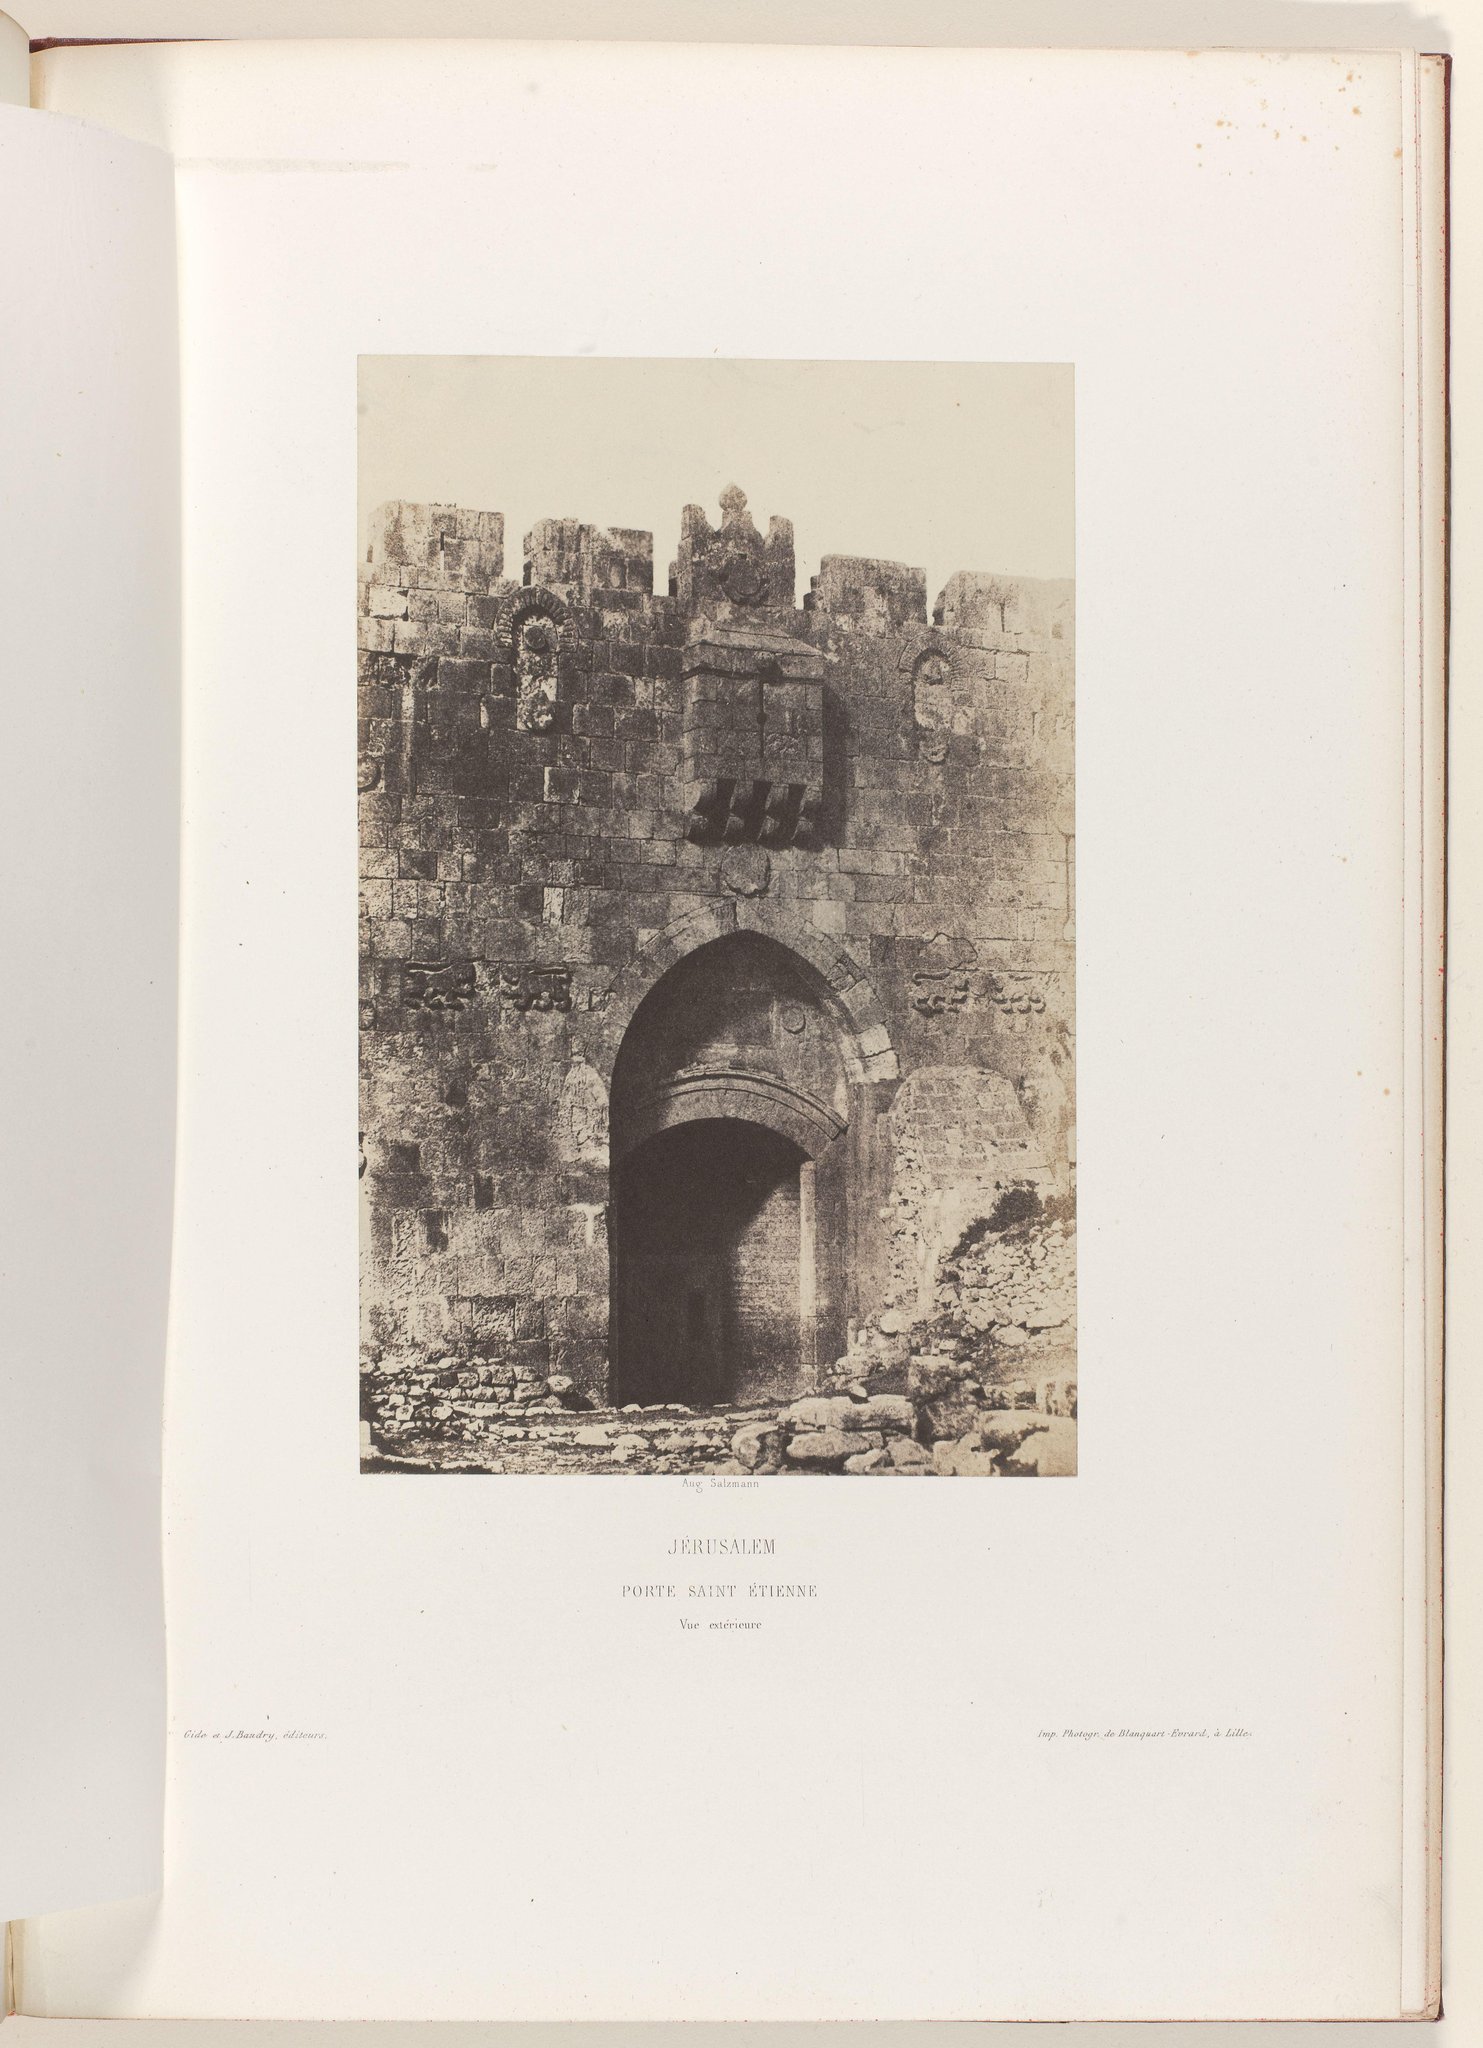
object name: photograph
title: Leeuwenpoort te Jeruzalem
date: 1854-1856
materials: cardboard, paper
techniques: salted paper print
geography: lille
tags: gate, entrance, city-gate